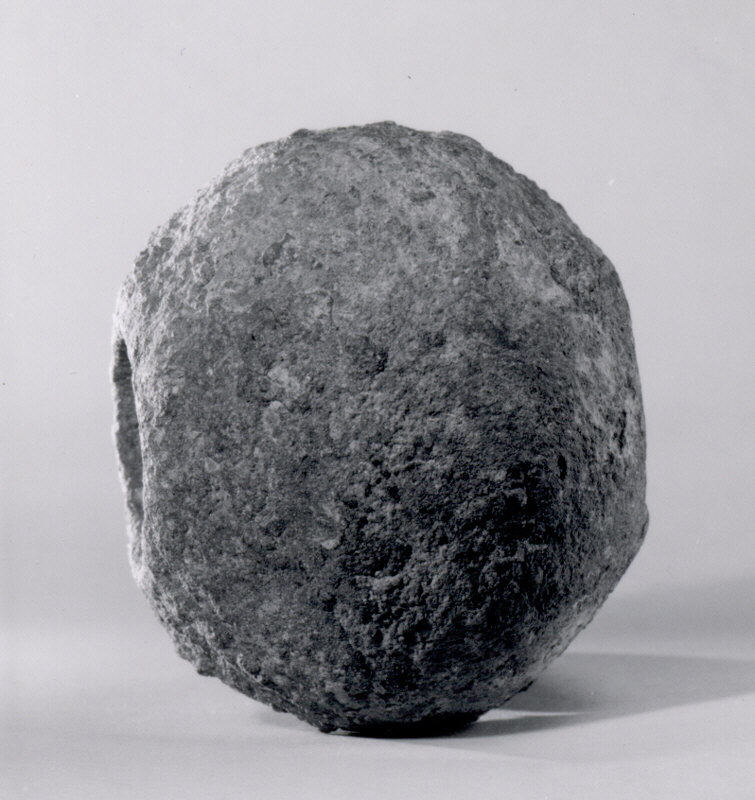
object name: mace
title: Mace head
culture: bactria-margiana archaeological complex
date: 2333-1668 BCE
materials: copper alloy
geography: bactria-margiana